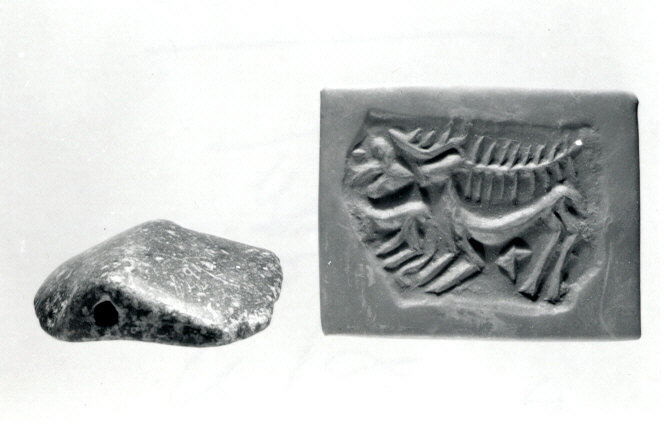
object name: stamp seal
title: Carinated ovoid seal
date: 3600-3100 BCE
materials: mineral, stone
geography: northern syria or southeastern anatolia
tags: animals